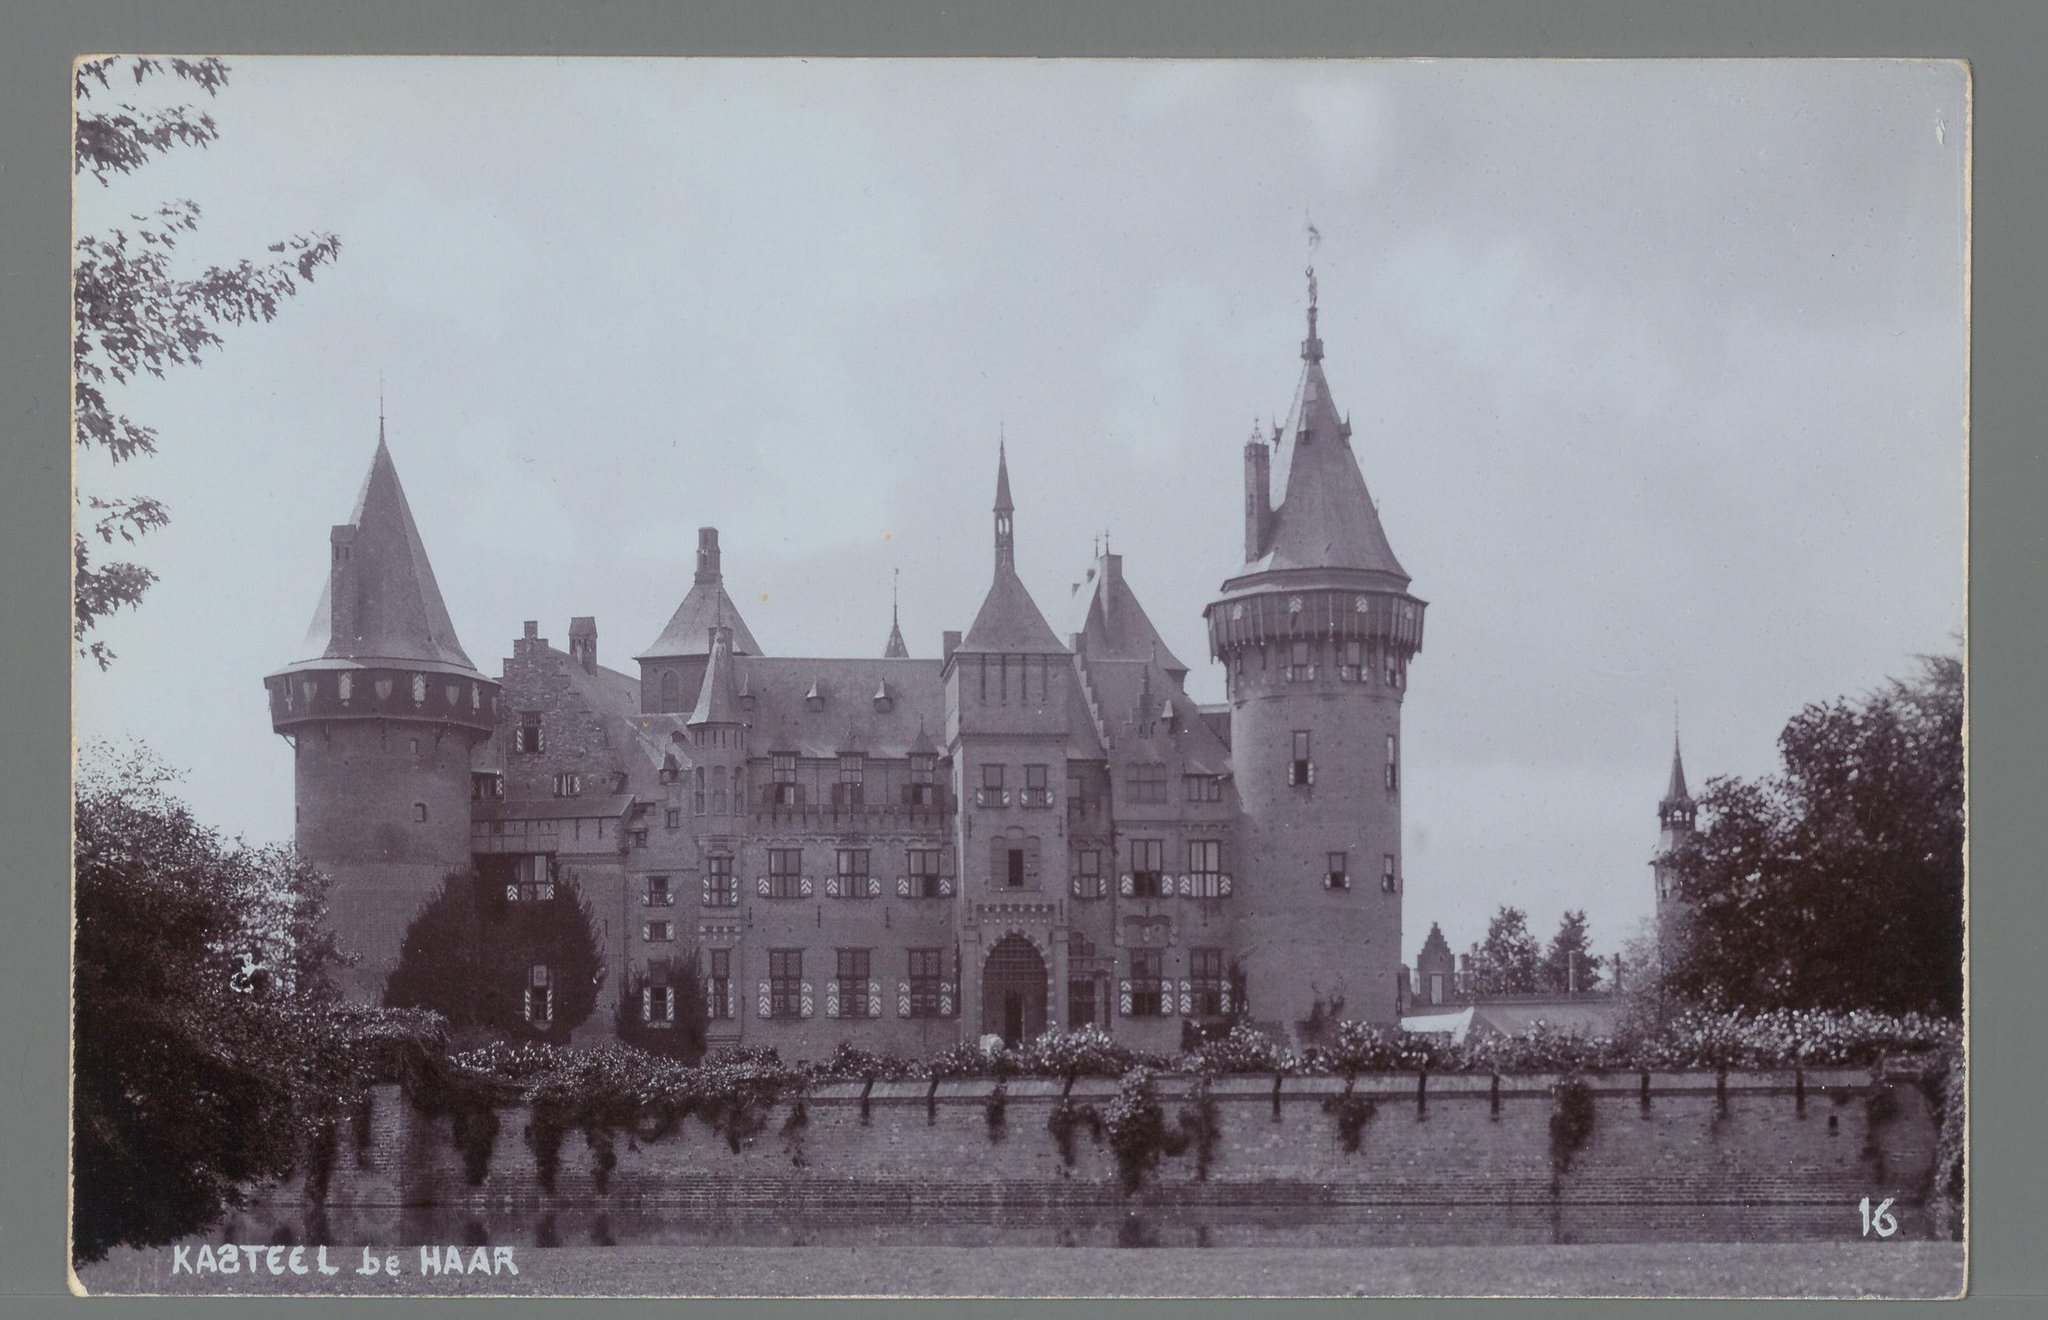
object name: photograph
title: Kasteel de Haar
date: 1900-1930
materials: paper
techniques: collodion silver print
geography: haarzuilens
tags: castle, canal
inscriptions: monogram: ‘M.R.A. U.’